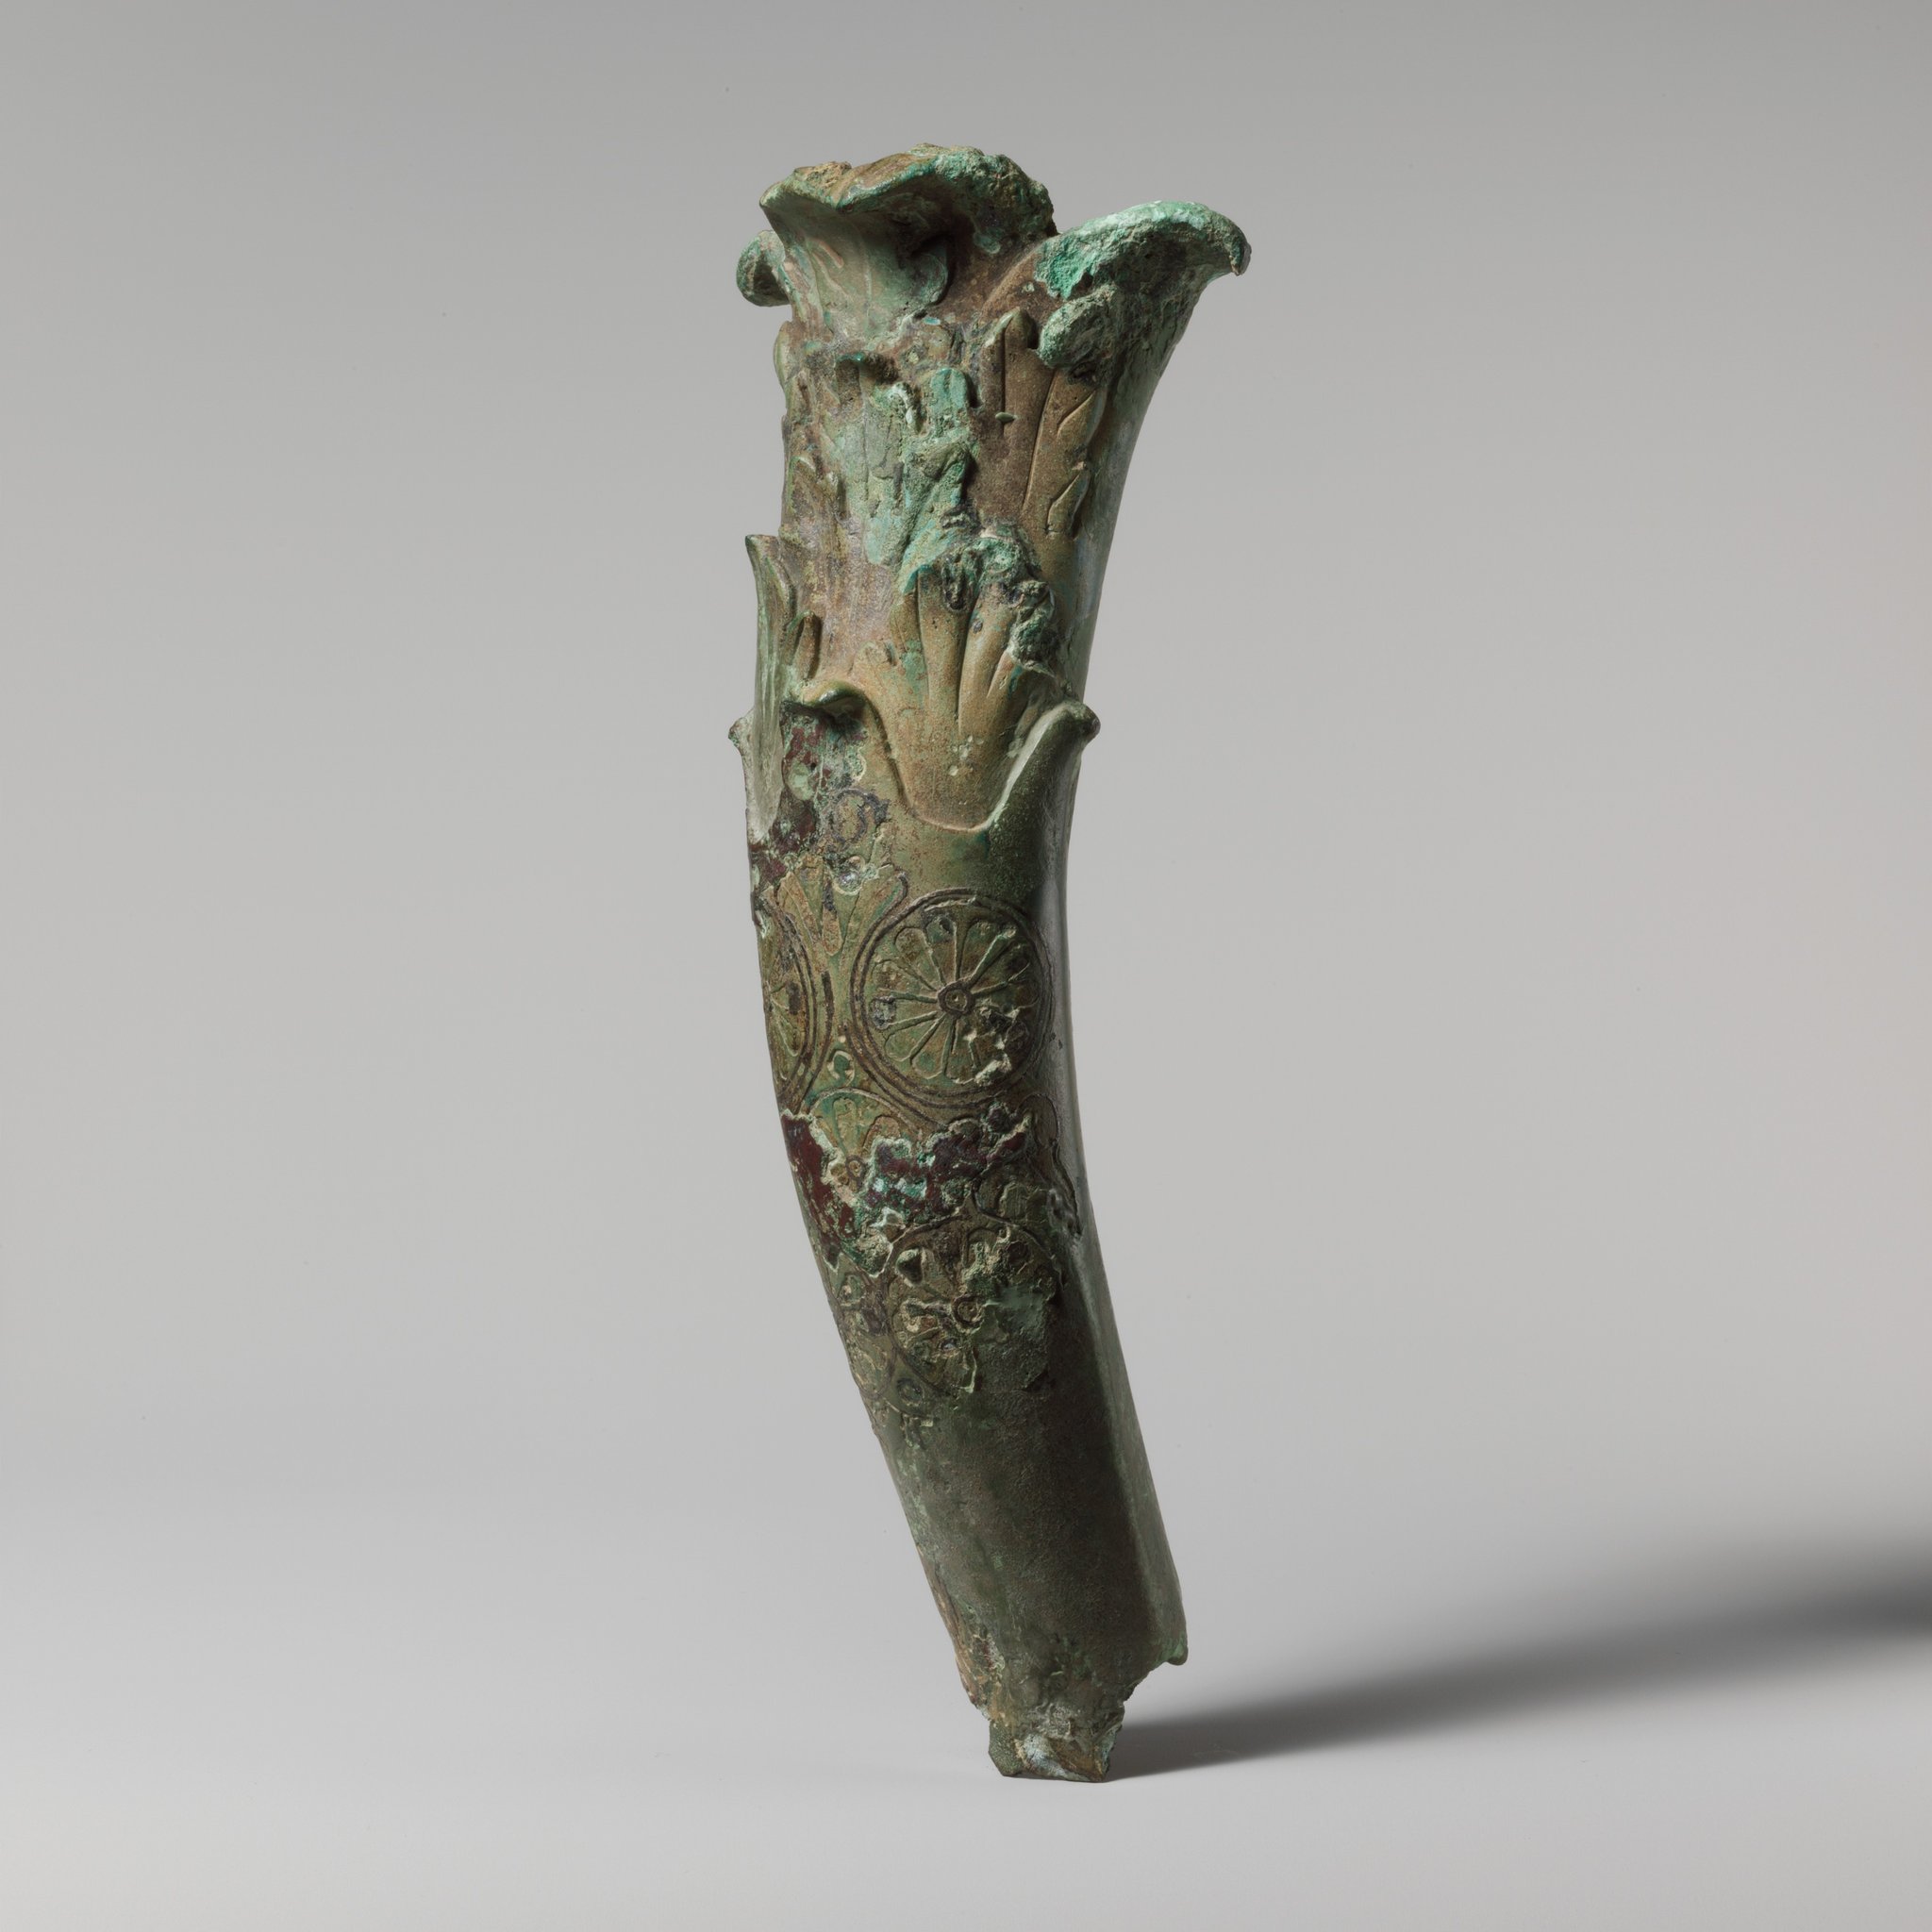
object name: object in shape of a horn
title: Bronze object in the shape of a horn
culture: roman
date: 1-200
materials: bronze, copper, niello, silver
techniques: inlay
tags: acanthus